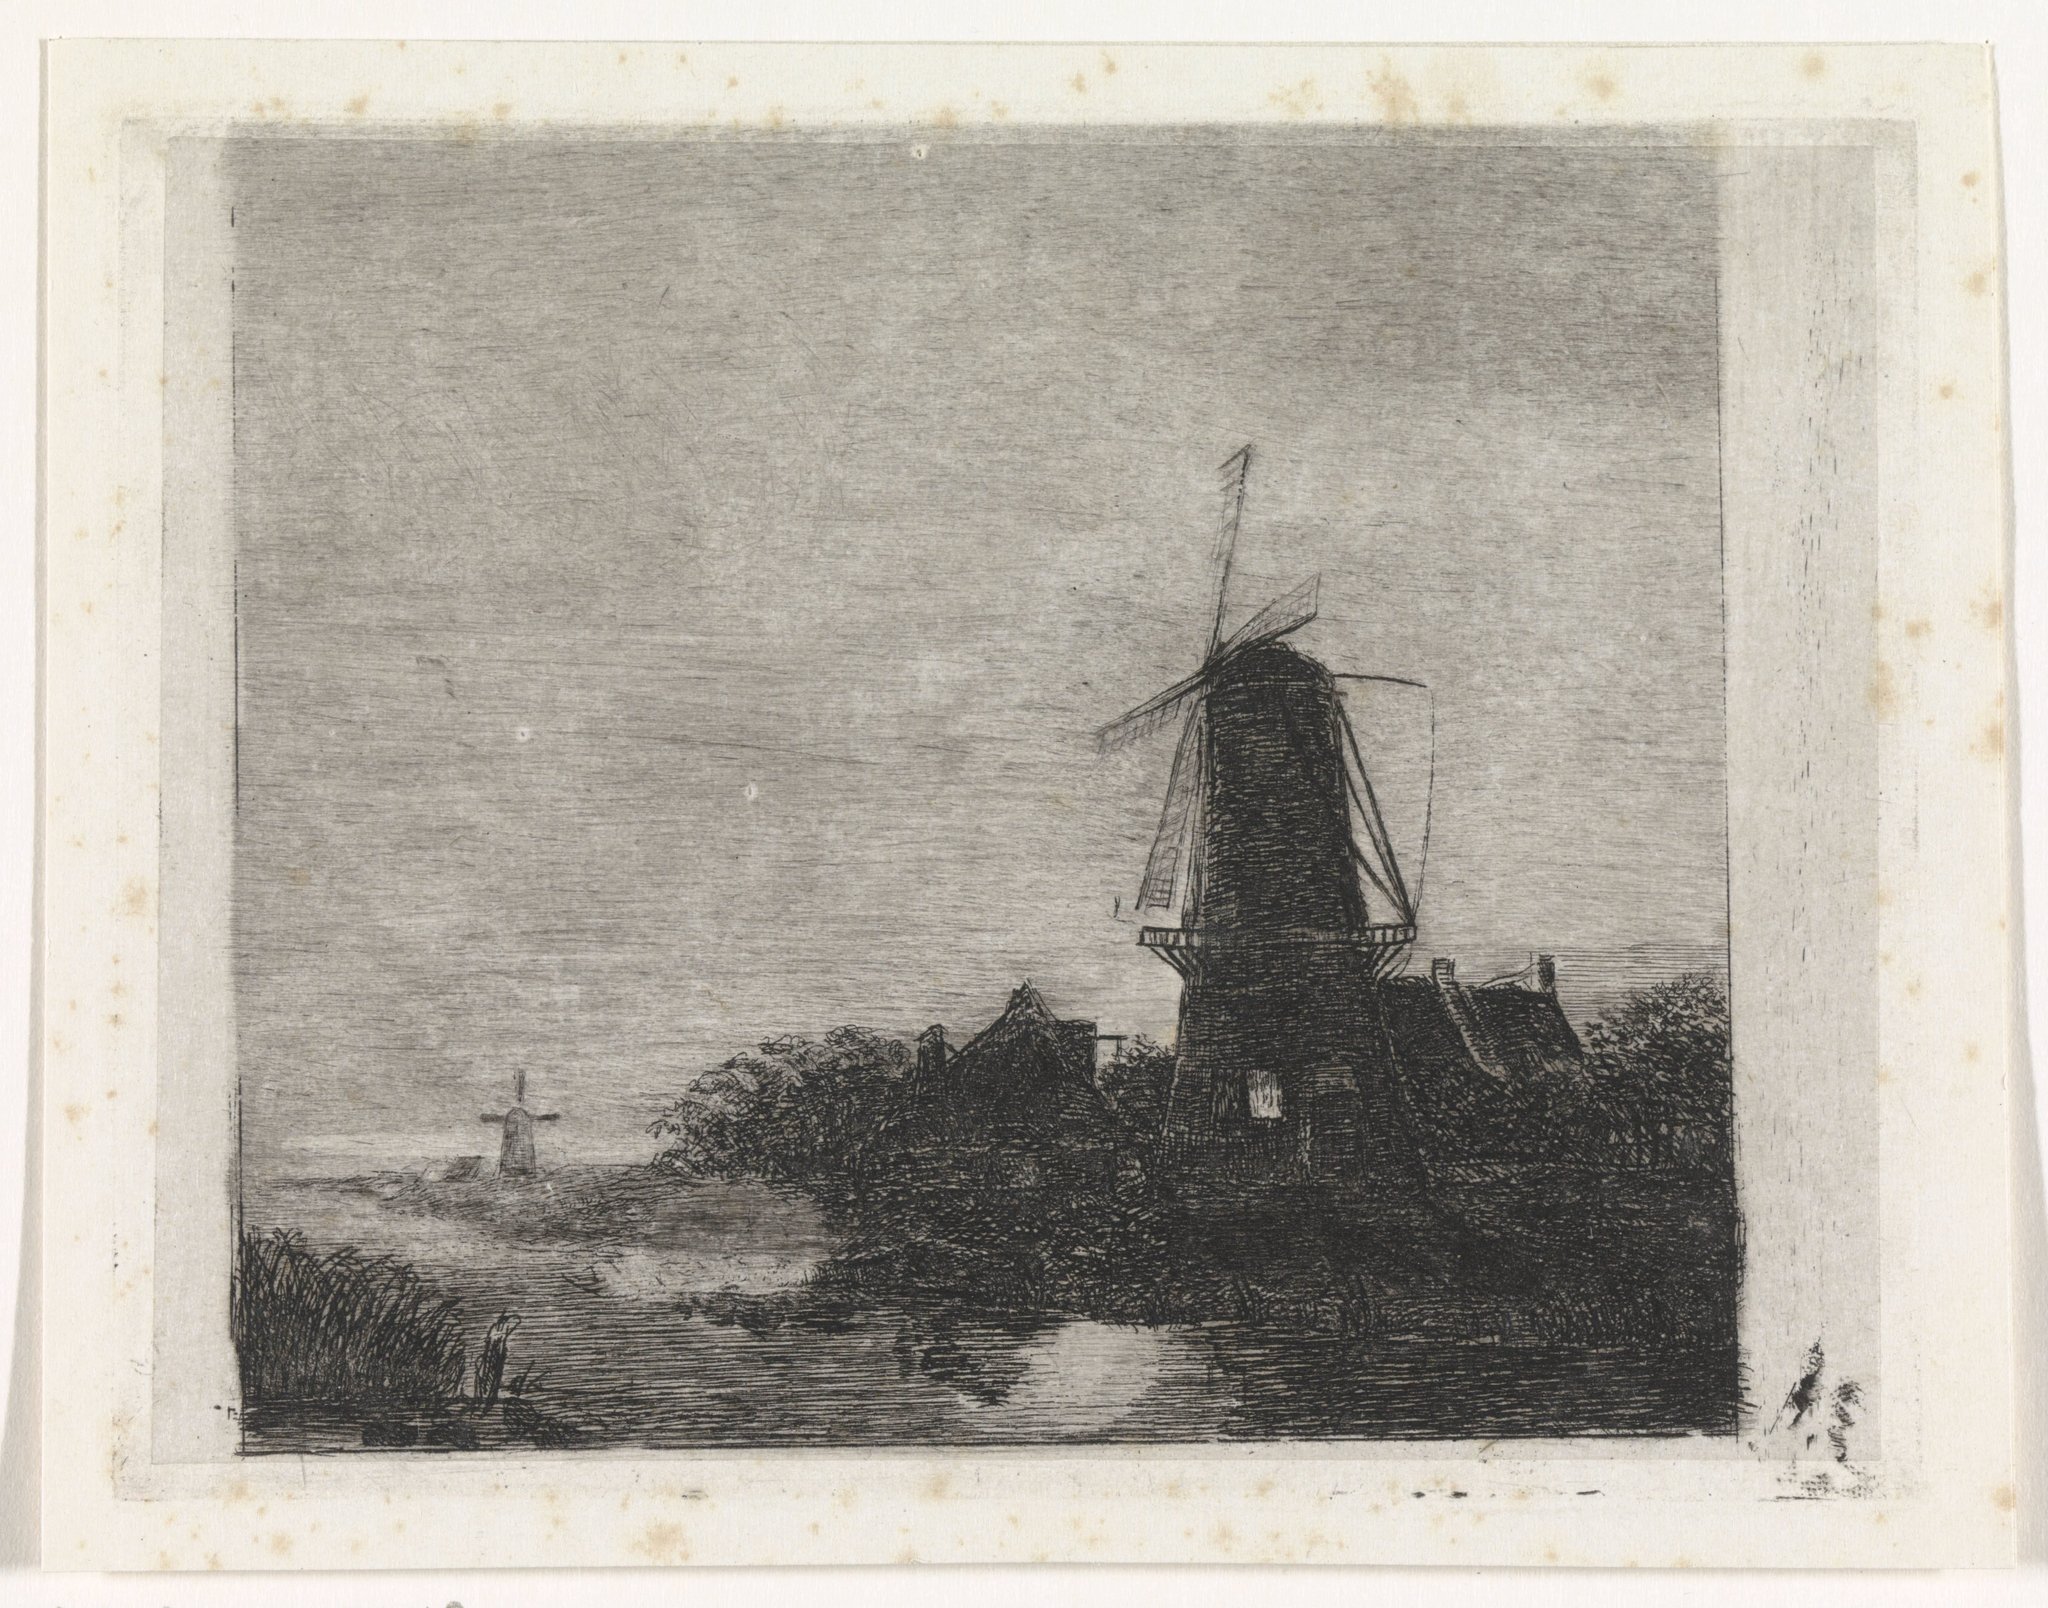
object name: print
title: Molens aan een vaart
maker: johan philip van der kellen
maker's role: draughtsman, print maker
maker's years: 1831-1906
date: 1841-1906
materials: paper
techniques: drypoint, etching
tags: windmill in landscape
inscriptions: collector's mark: Lugt 2228, collector's mark: Lugt 1485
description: Avondlandschap met twee molens en huizen aan een vaart. In de molen op de voorgrond brandt licht.